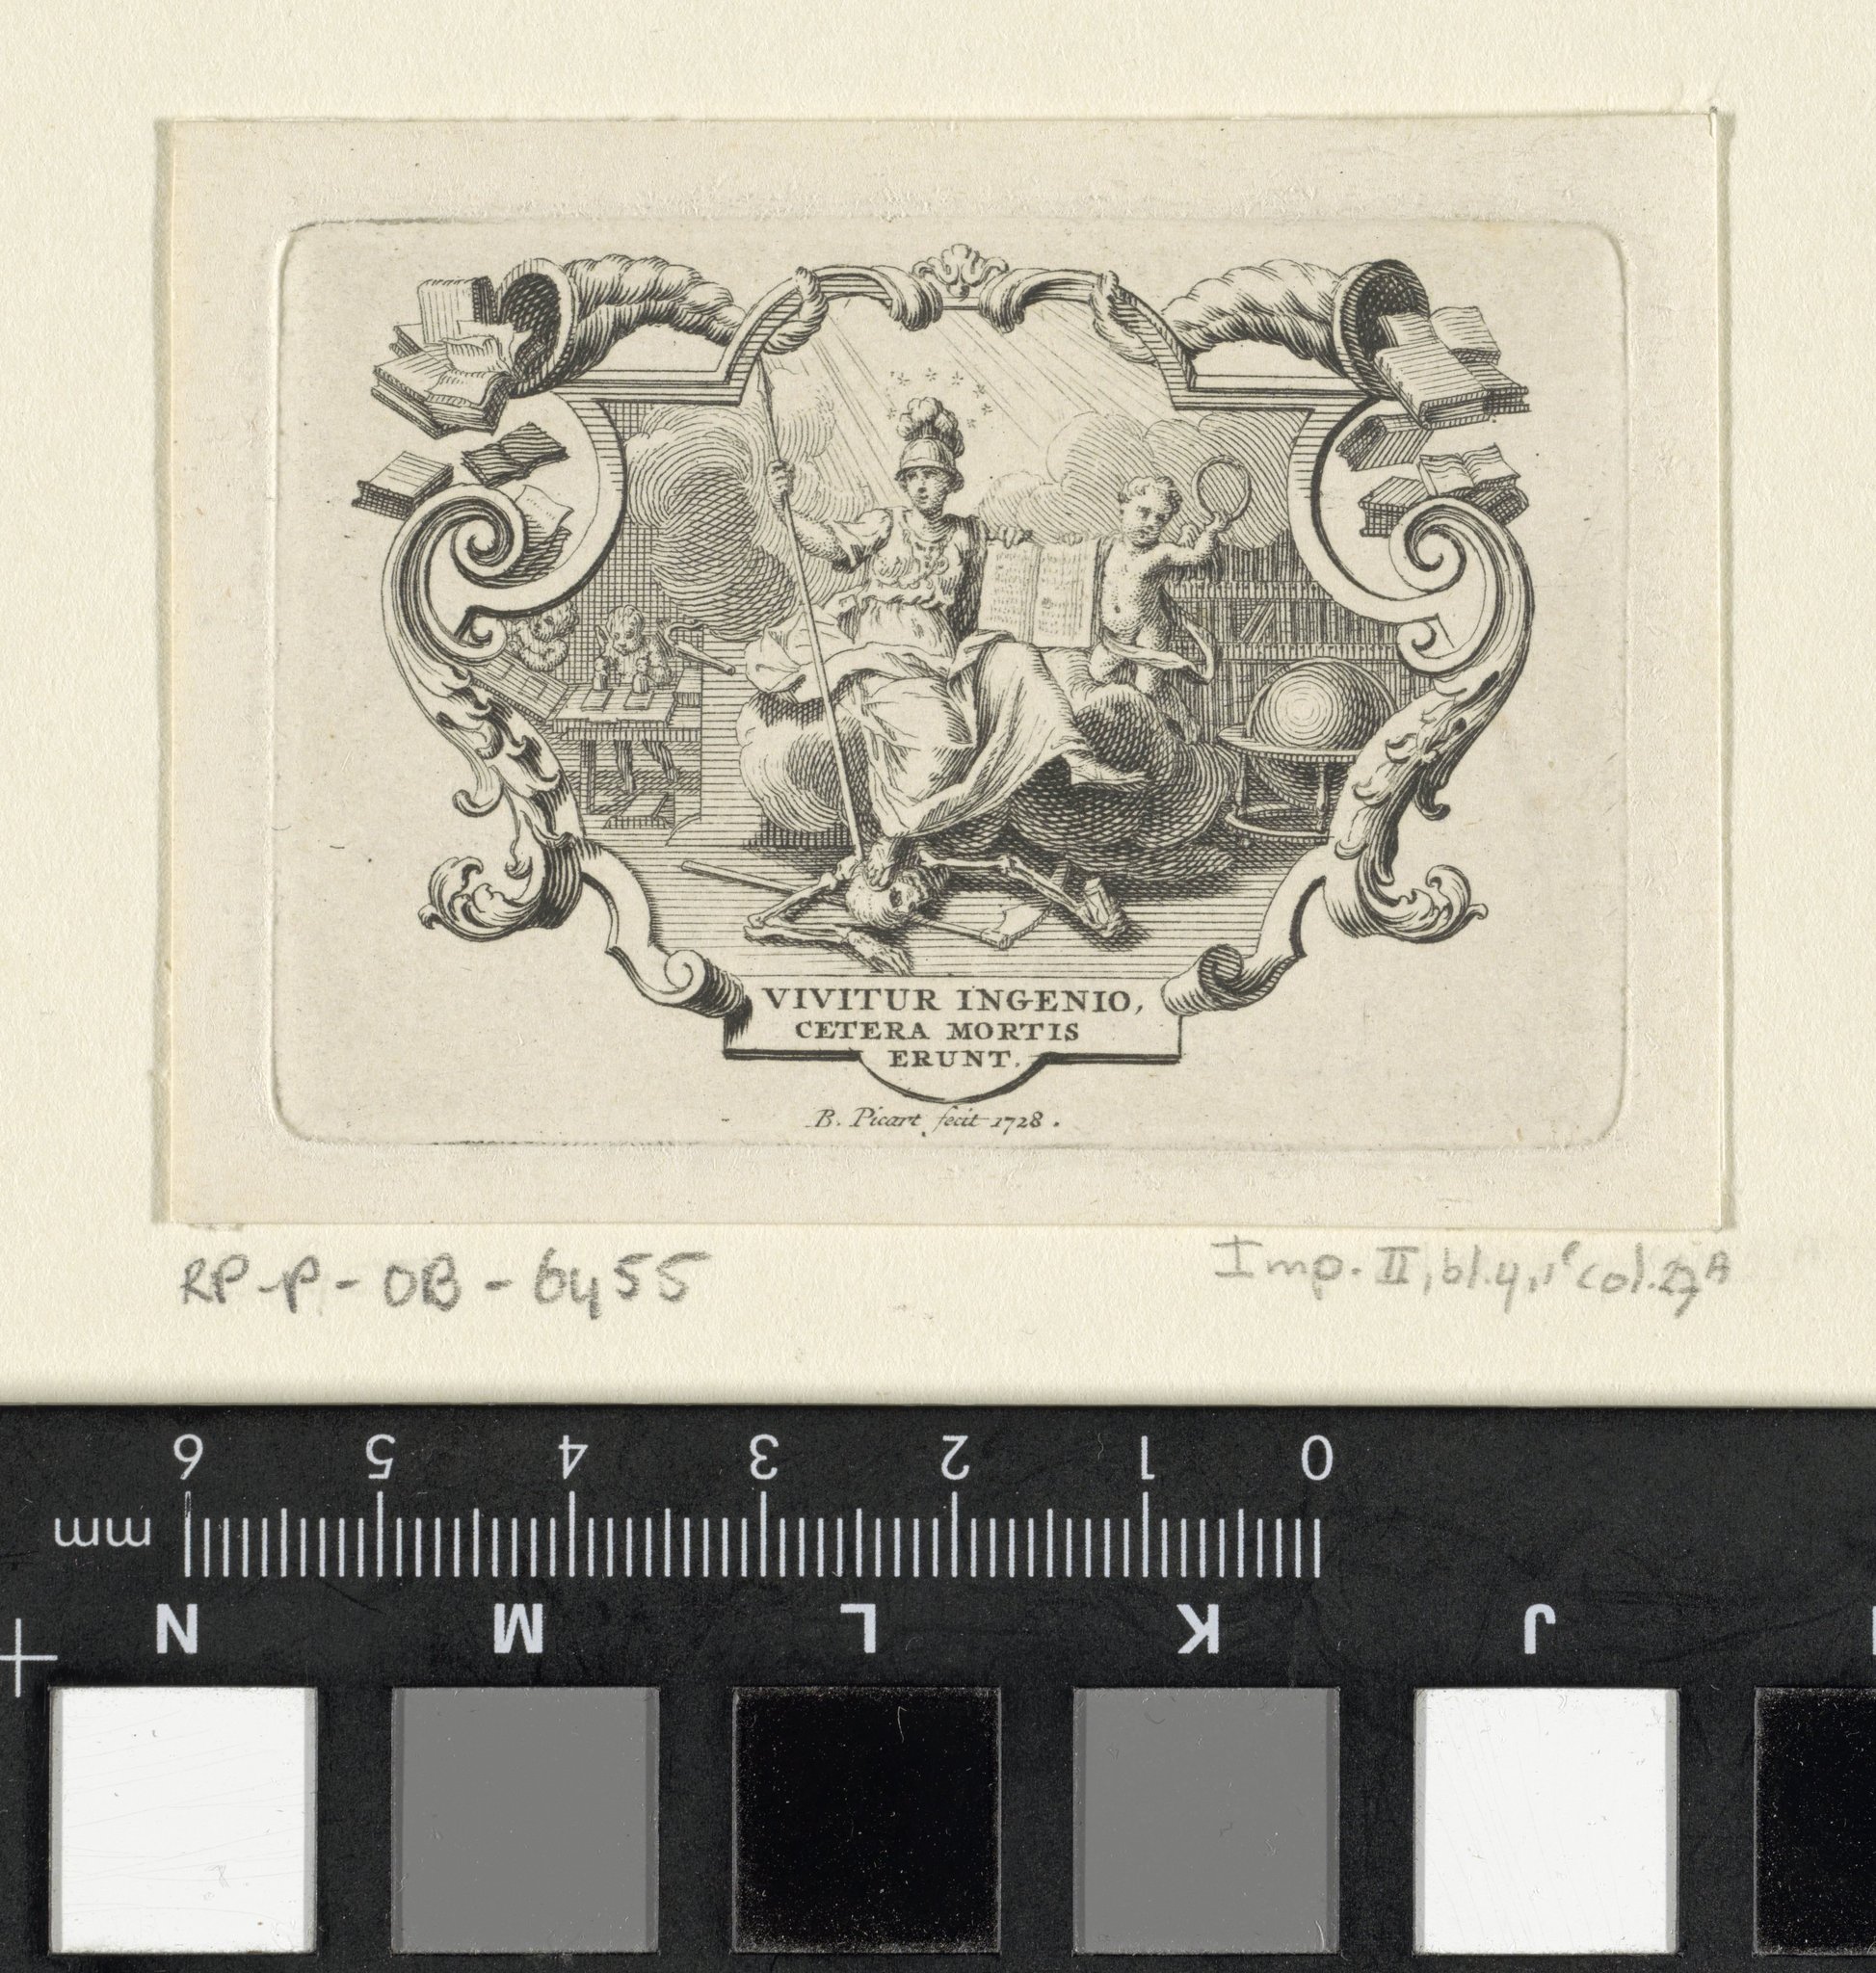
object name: print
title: Vignet met Minerva en Amor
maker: bernard picart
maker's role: draughtsman, print maker, publisher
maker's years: 1673-1733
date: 1728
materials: paper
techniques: engraving, etching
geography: amsterdam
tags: minerva as patroness, ornaments ~ art, book, serpent ouroboros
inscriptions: collector's mark: Lugt 240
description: Minerva zit als patroon van de wetenschap op een wolk en toont een opengeslagen boek. Ze heeft de dood overwonnen, die in de gedaante van een skelet onder haar voeten ligt. Naast haar zit Amor met een cirkelvormige slang die zijn staart in de bek neemt: een symbool voor eeuwigheid. Links op de achtergrond putti die boeken drukken. De voorstelling is gevat in een ornamentele omlijsting met onder andere hoornen des overvloeds met boeken. Midden onder het devies: Vivitur Ingenio, cetera mortis erunt.